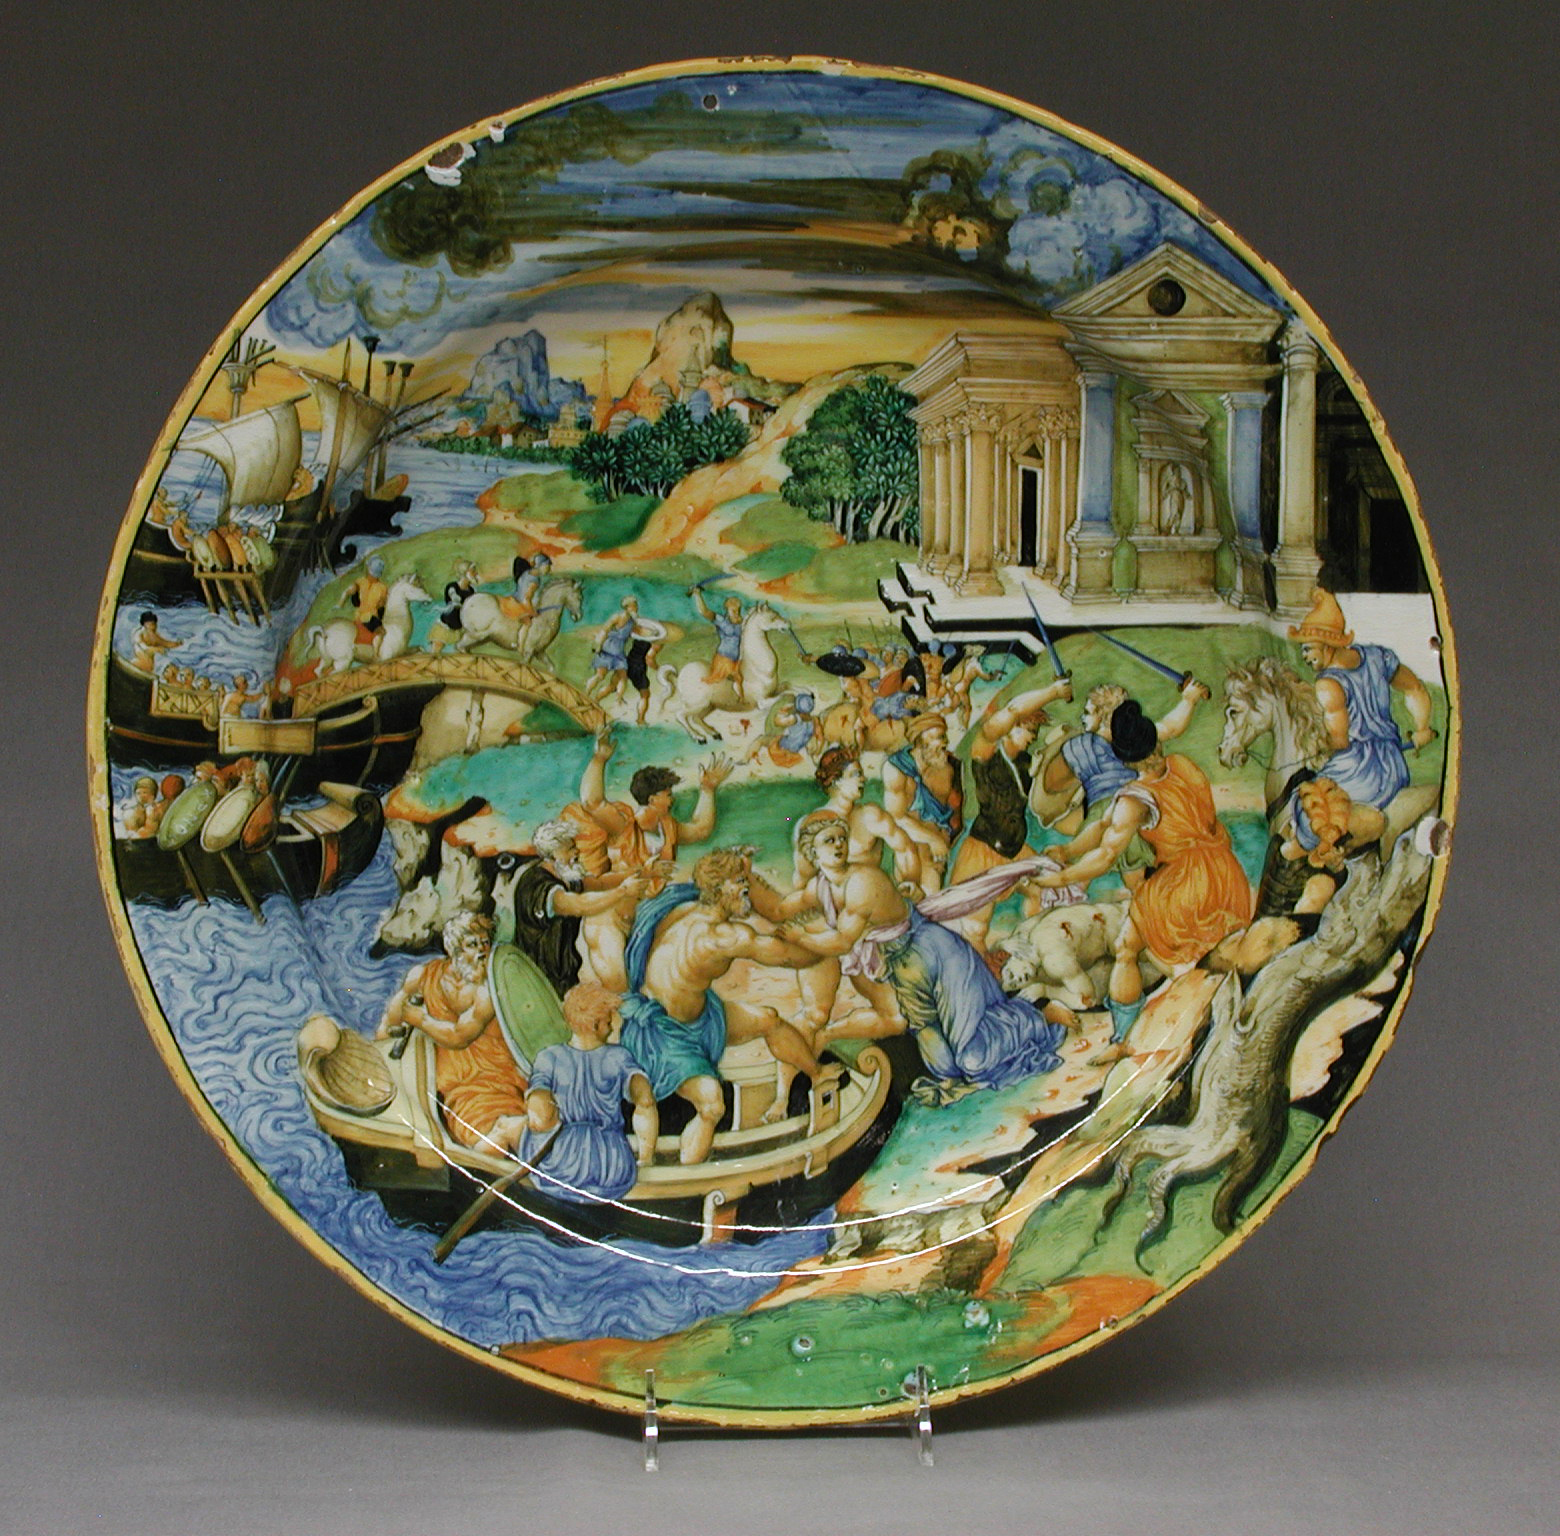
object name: dish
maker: fra xanto avelli da rovigo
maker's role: artist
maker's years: 1486-1582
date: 1530-1535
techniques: maiolica, glazing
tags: men,women,horses,boats